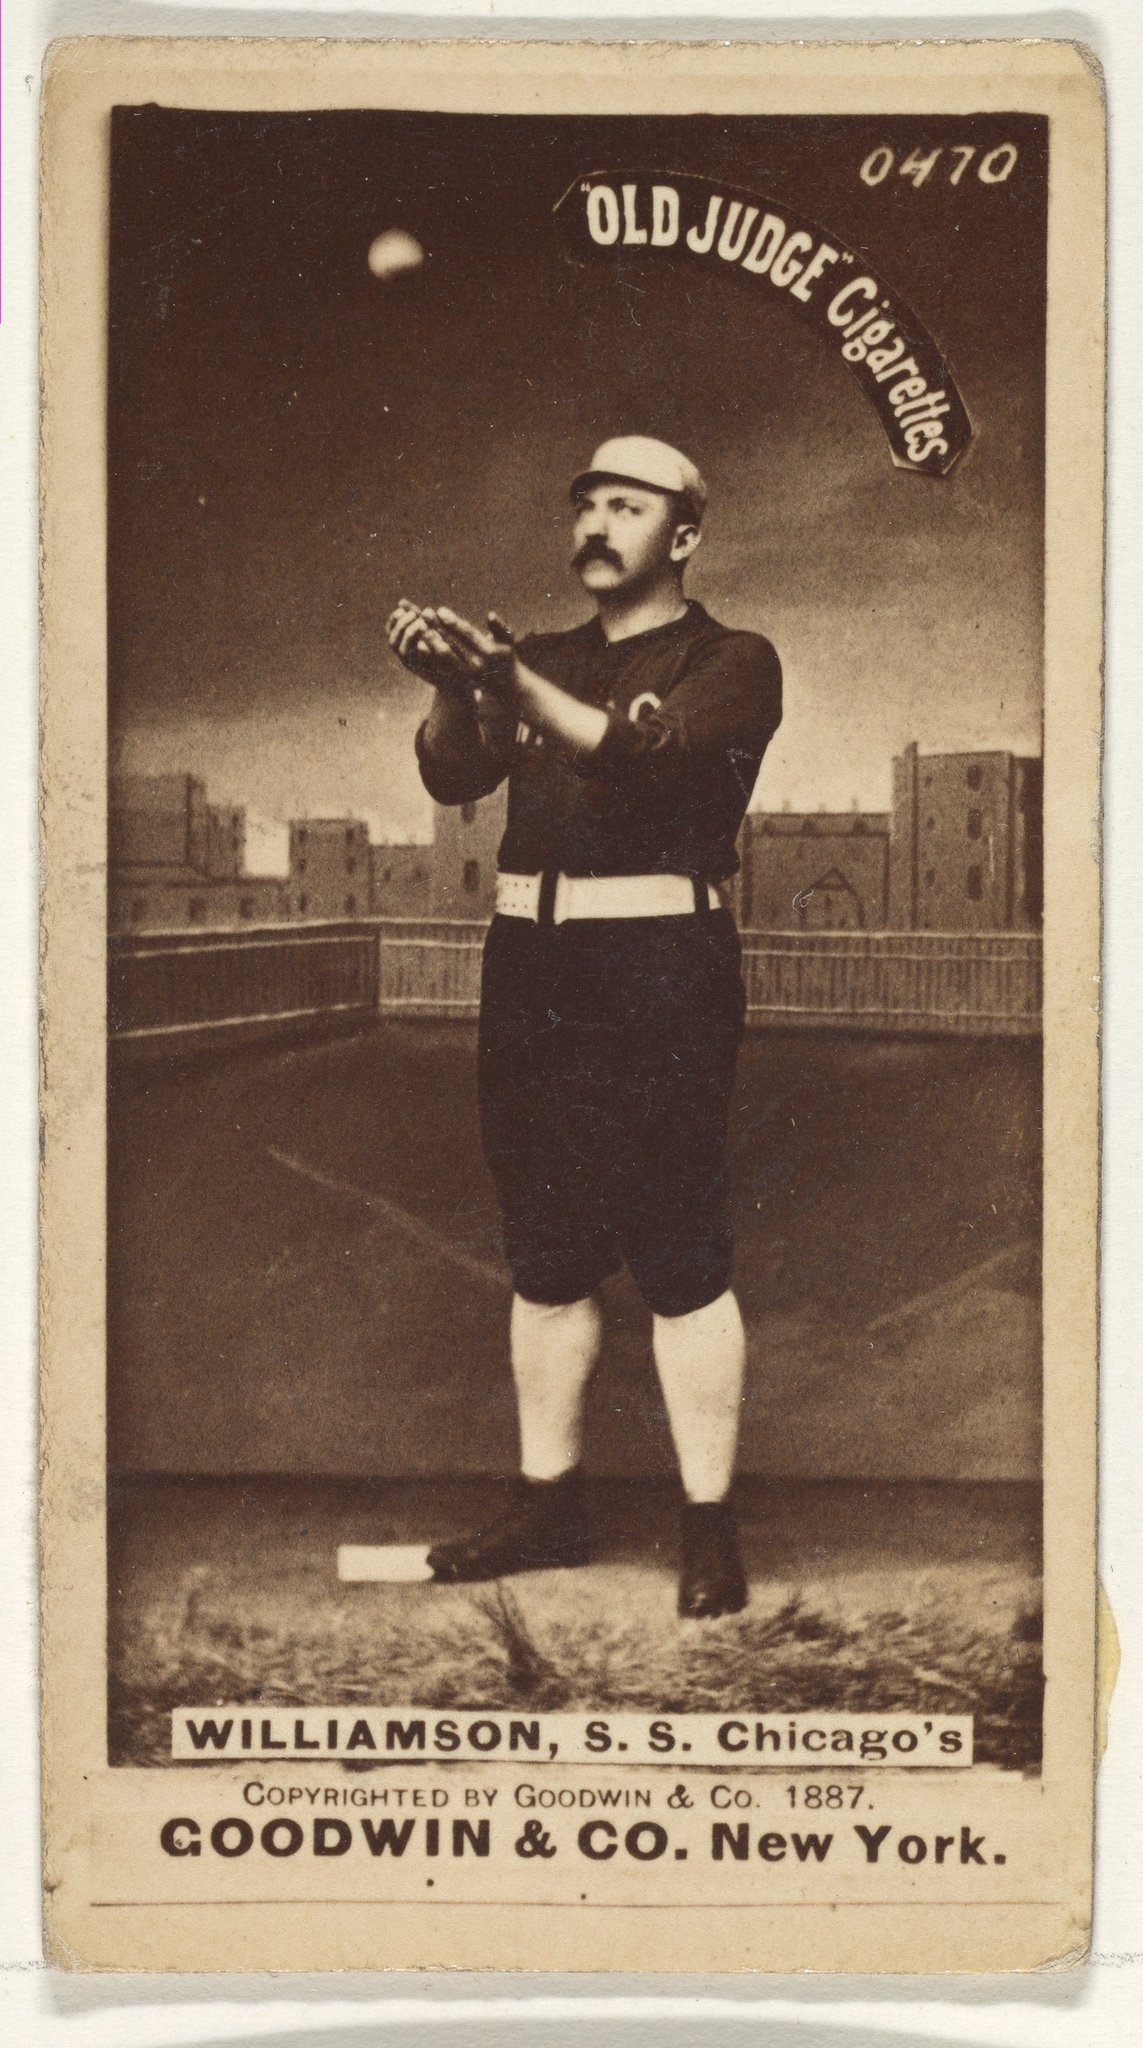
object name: baseball card, photograph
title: Williamson, Shortstop, Chicago, from the Old Judge series (N172) for Old Judge Cigarettes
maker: goodwin & company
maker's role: publisher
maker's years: 1850-1950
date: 1887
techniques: albumen silver print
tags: men,portraits,baseball,athletes